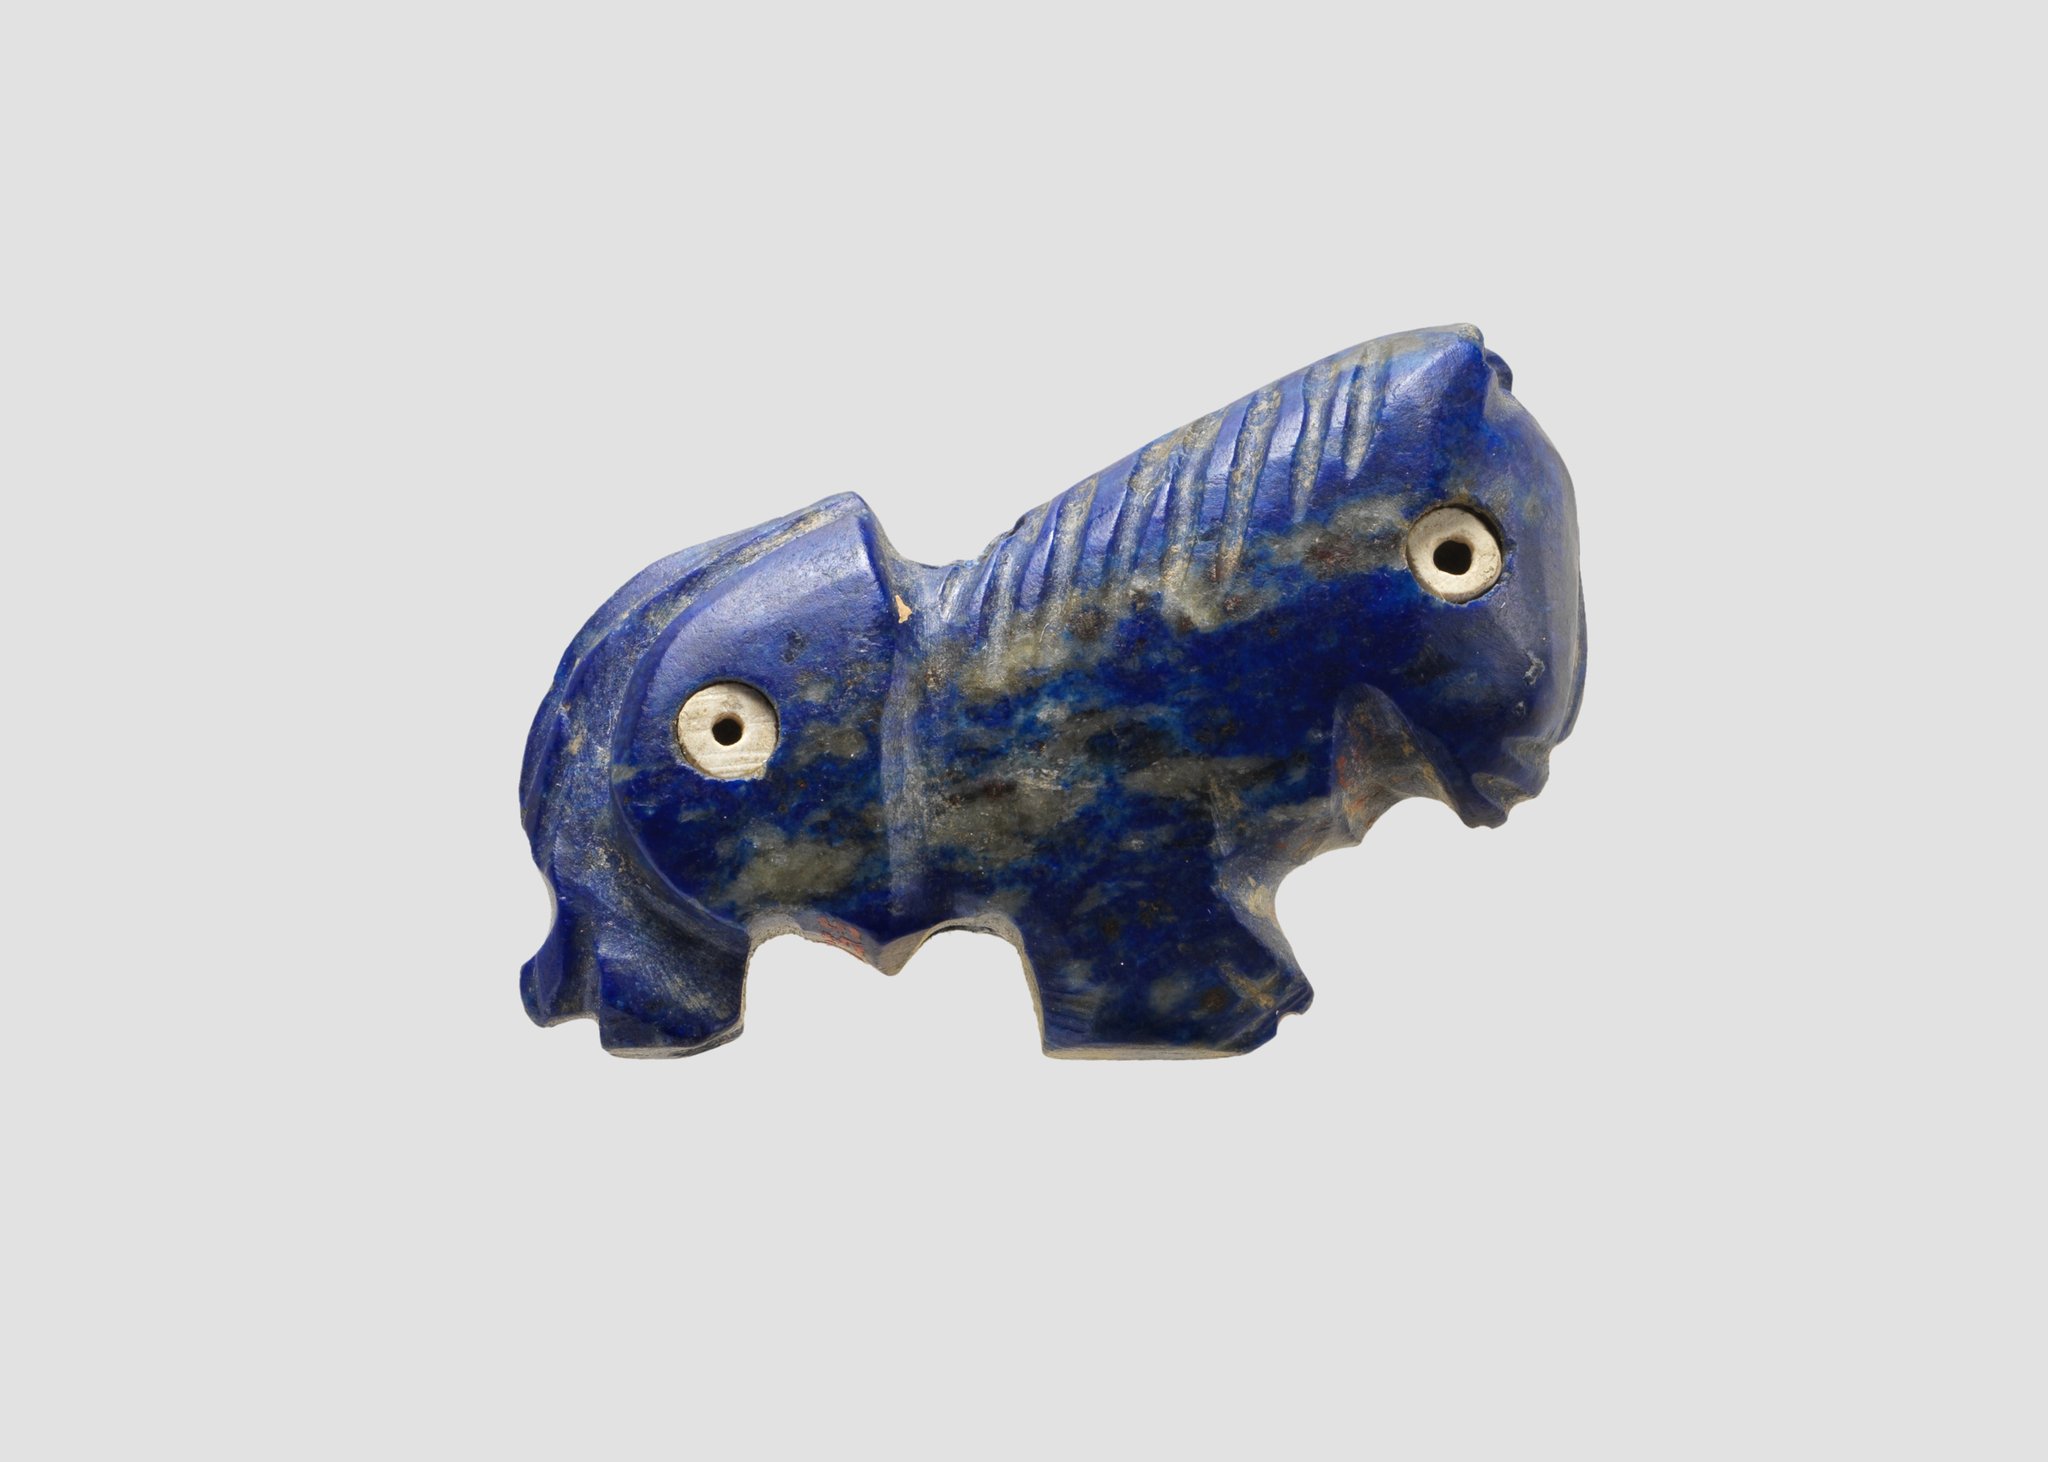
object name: necklace, bead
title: Amulet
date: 4000-3001 BCE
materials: lapis lazuli, shell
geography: mesopotamia